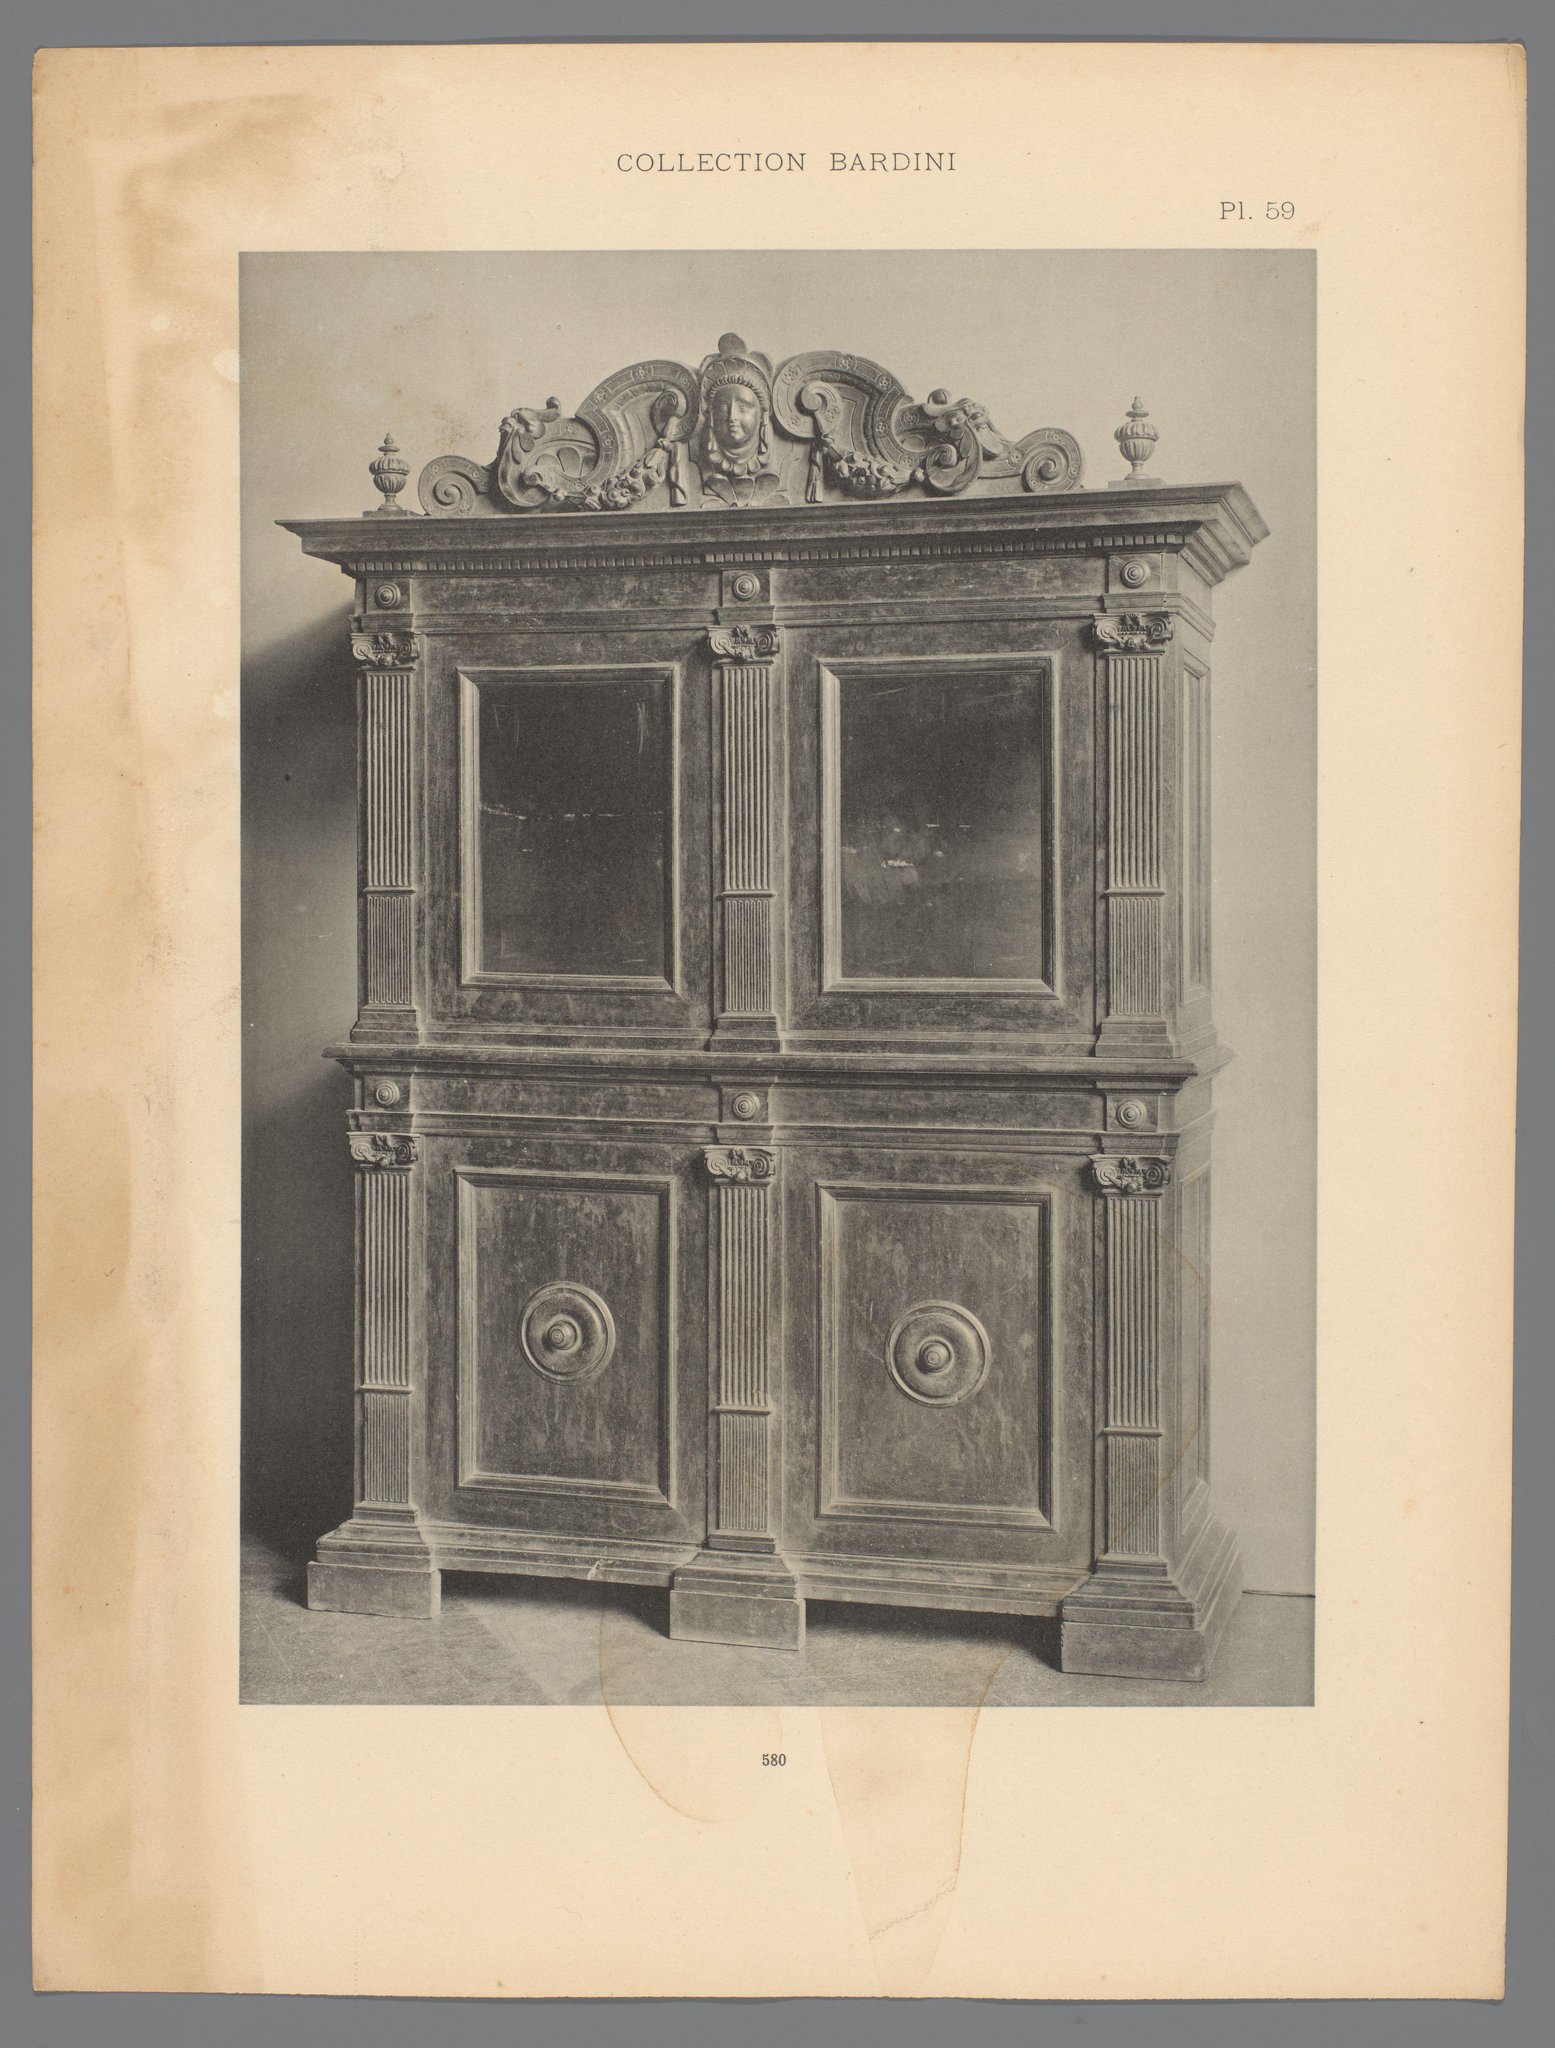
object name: photomechanical print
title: Gedecoreerd kabinet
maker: Anonymous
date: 1875-1930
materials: paper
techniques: photograph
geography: florence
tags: ornamental cupboard (+ wood and other phytogenic material)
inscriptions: number: ‘Pl. 59’